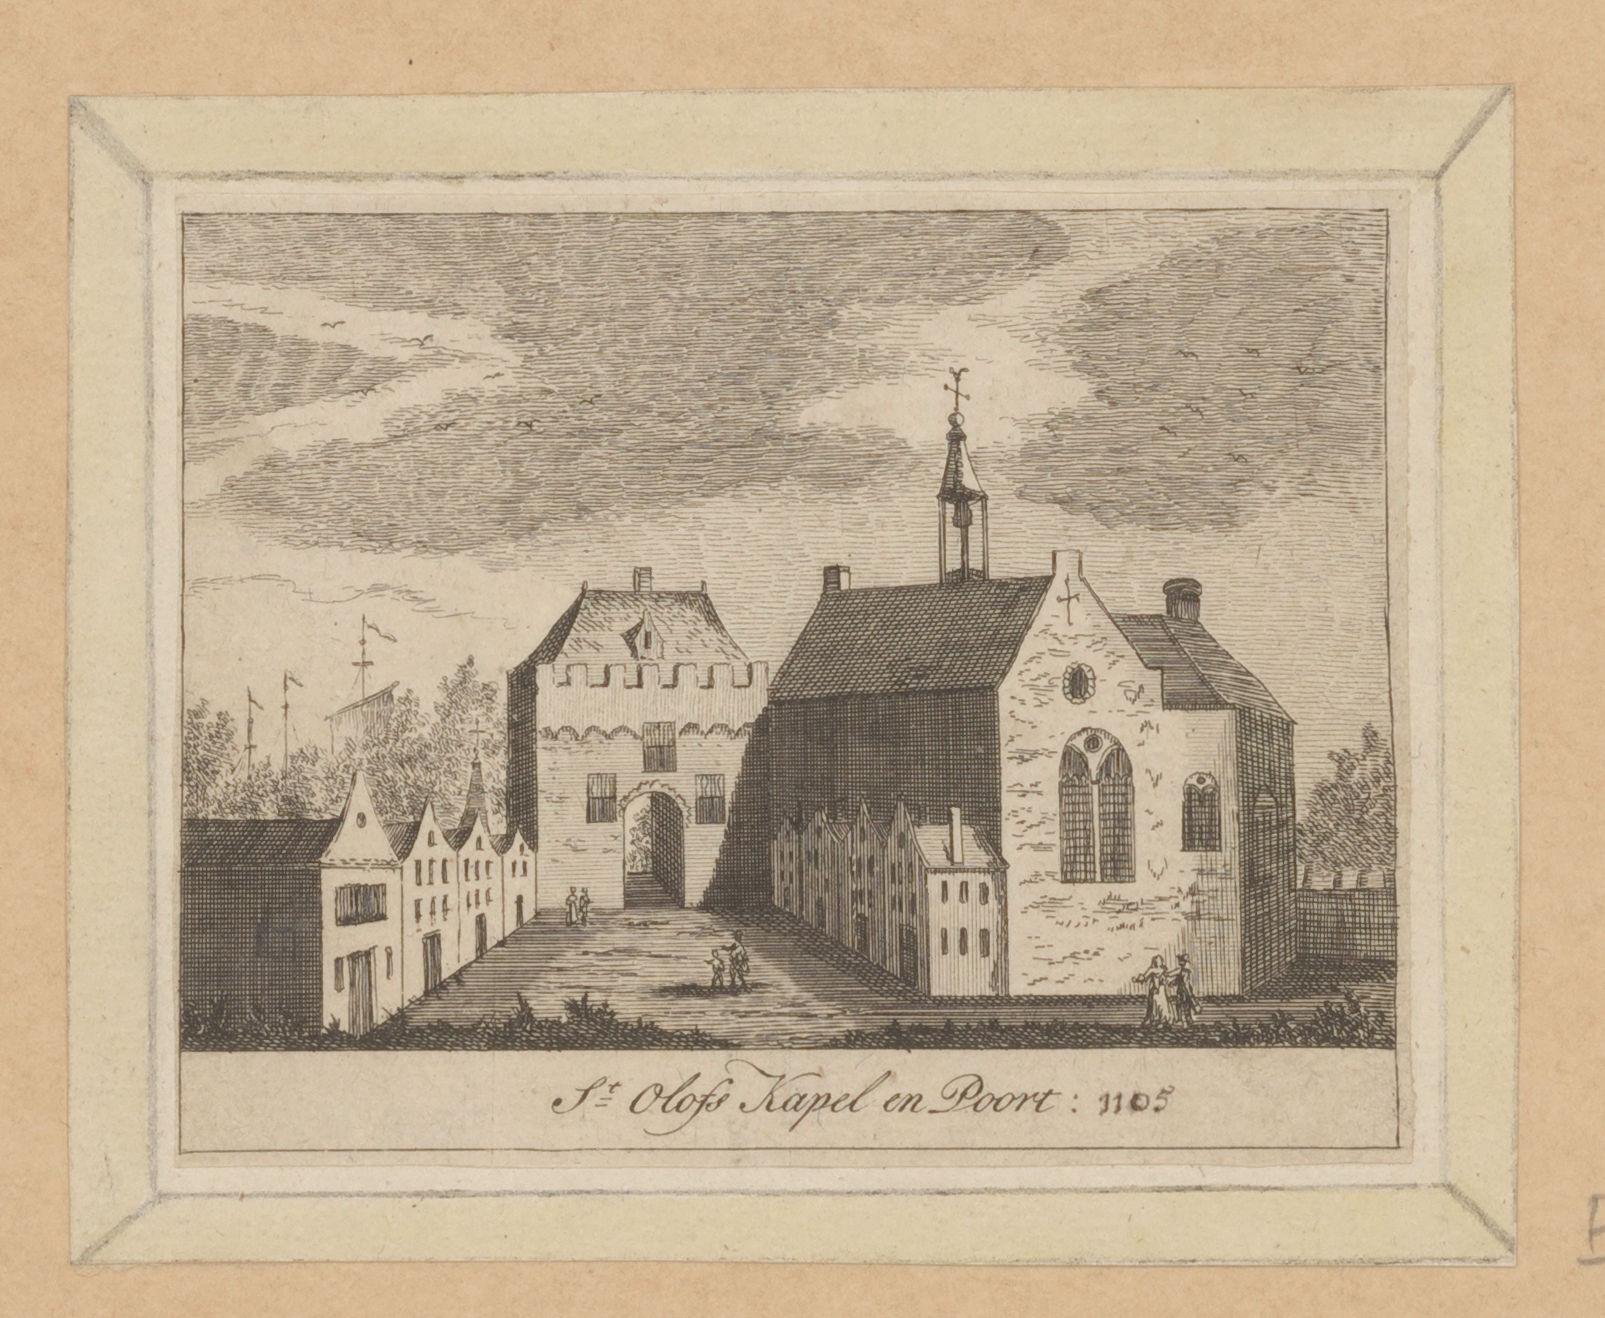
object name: print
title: Gezicht op de Sint-Olofspoort en Sint-Olofskapel (Oudezijds Kapel) te Amsterdam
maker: jan fokke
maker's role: print maker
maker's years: 1742-1812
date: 1752-1812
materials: paper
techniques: engraving, etching, letterpress printing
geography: northern netherlands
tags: church (exterior) - qq - small church, chapel, city-gate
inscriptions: collector's mark: ‘32.9A+B’ Lugt 1641b, inscription: ‘Uit een 18de E. Al[...] Door J. Fokke’, inscription: ‘: 1105’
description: Onderwerpsrubriek binnen de Atlas Amsterdam: Kerkwezen: Hervormde Gemeente: Oudezijds Kapel.